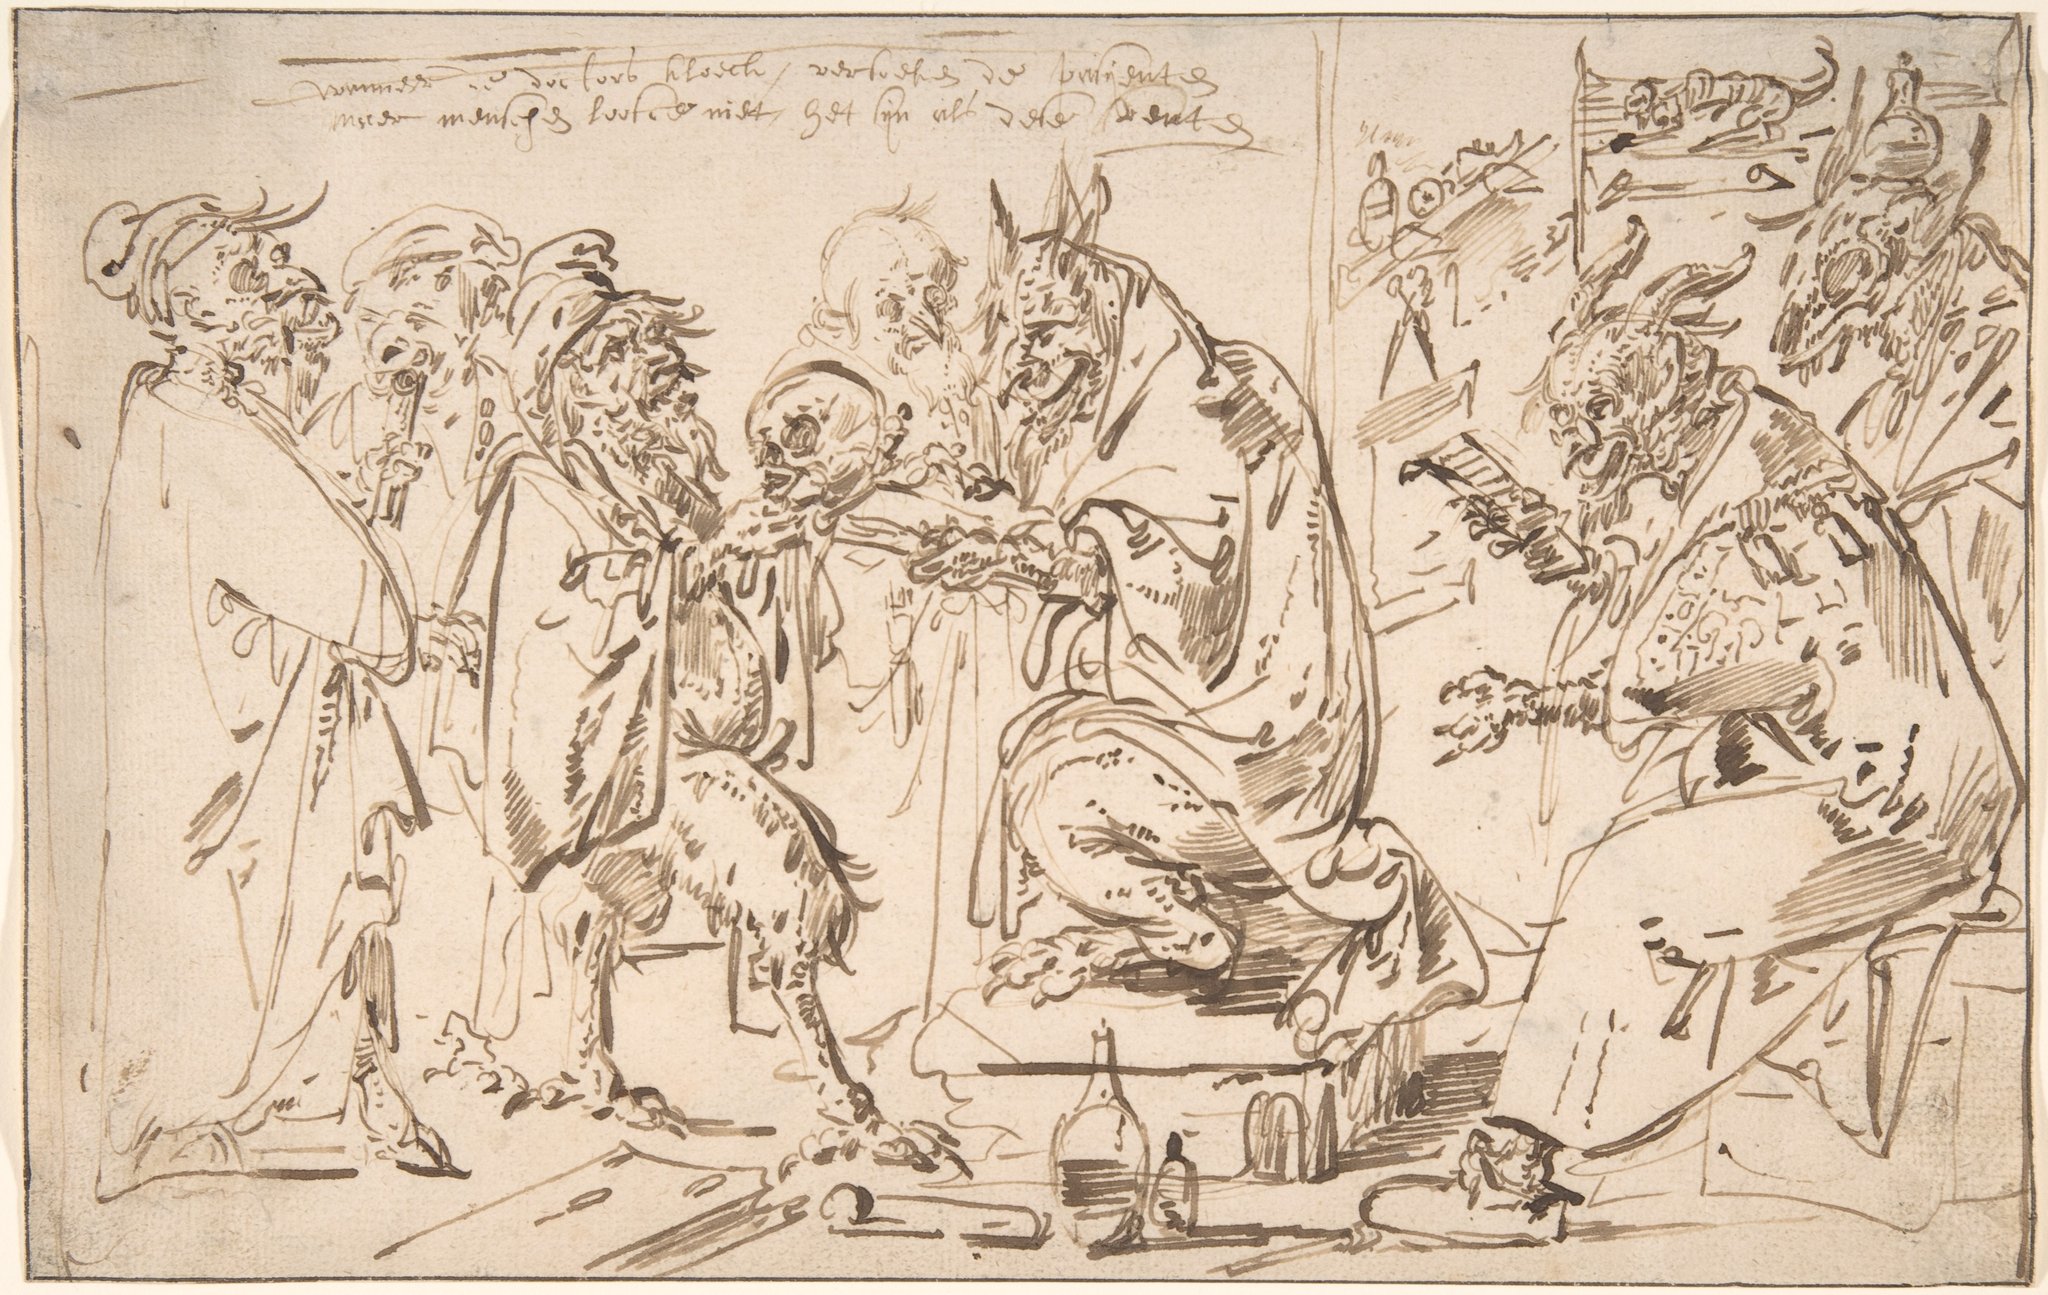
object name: drawing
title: Diablerie: A Satire on the Medical Profession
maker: andries both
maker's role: artist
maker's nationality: dutch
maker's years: 1612-1641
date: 1612-1641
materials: ink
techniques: pen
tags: satire,skulls,medicine,caricature